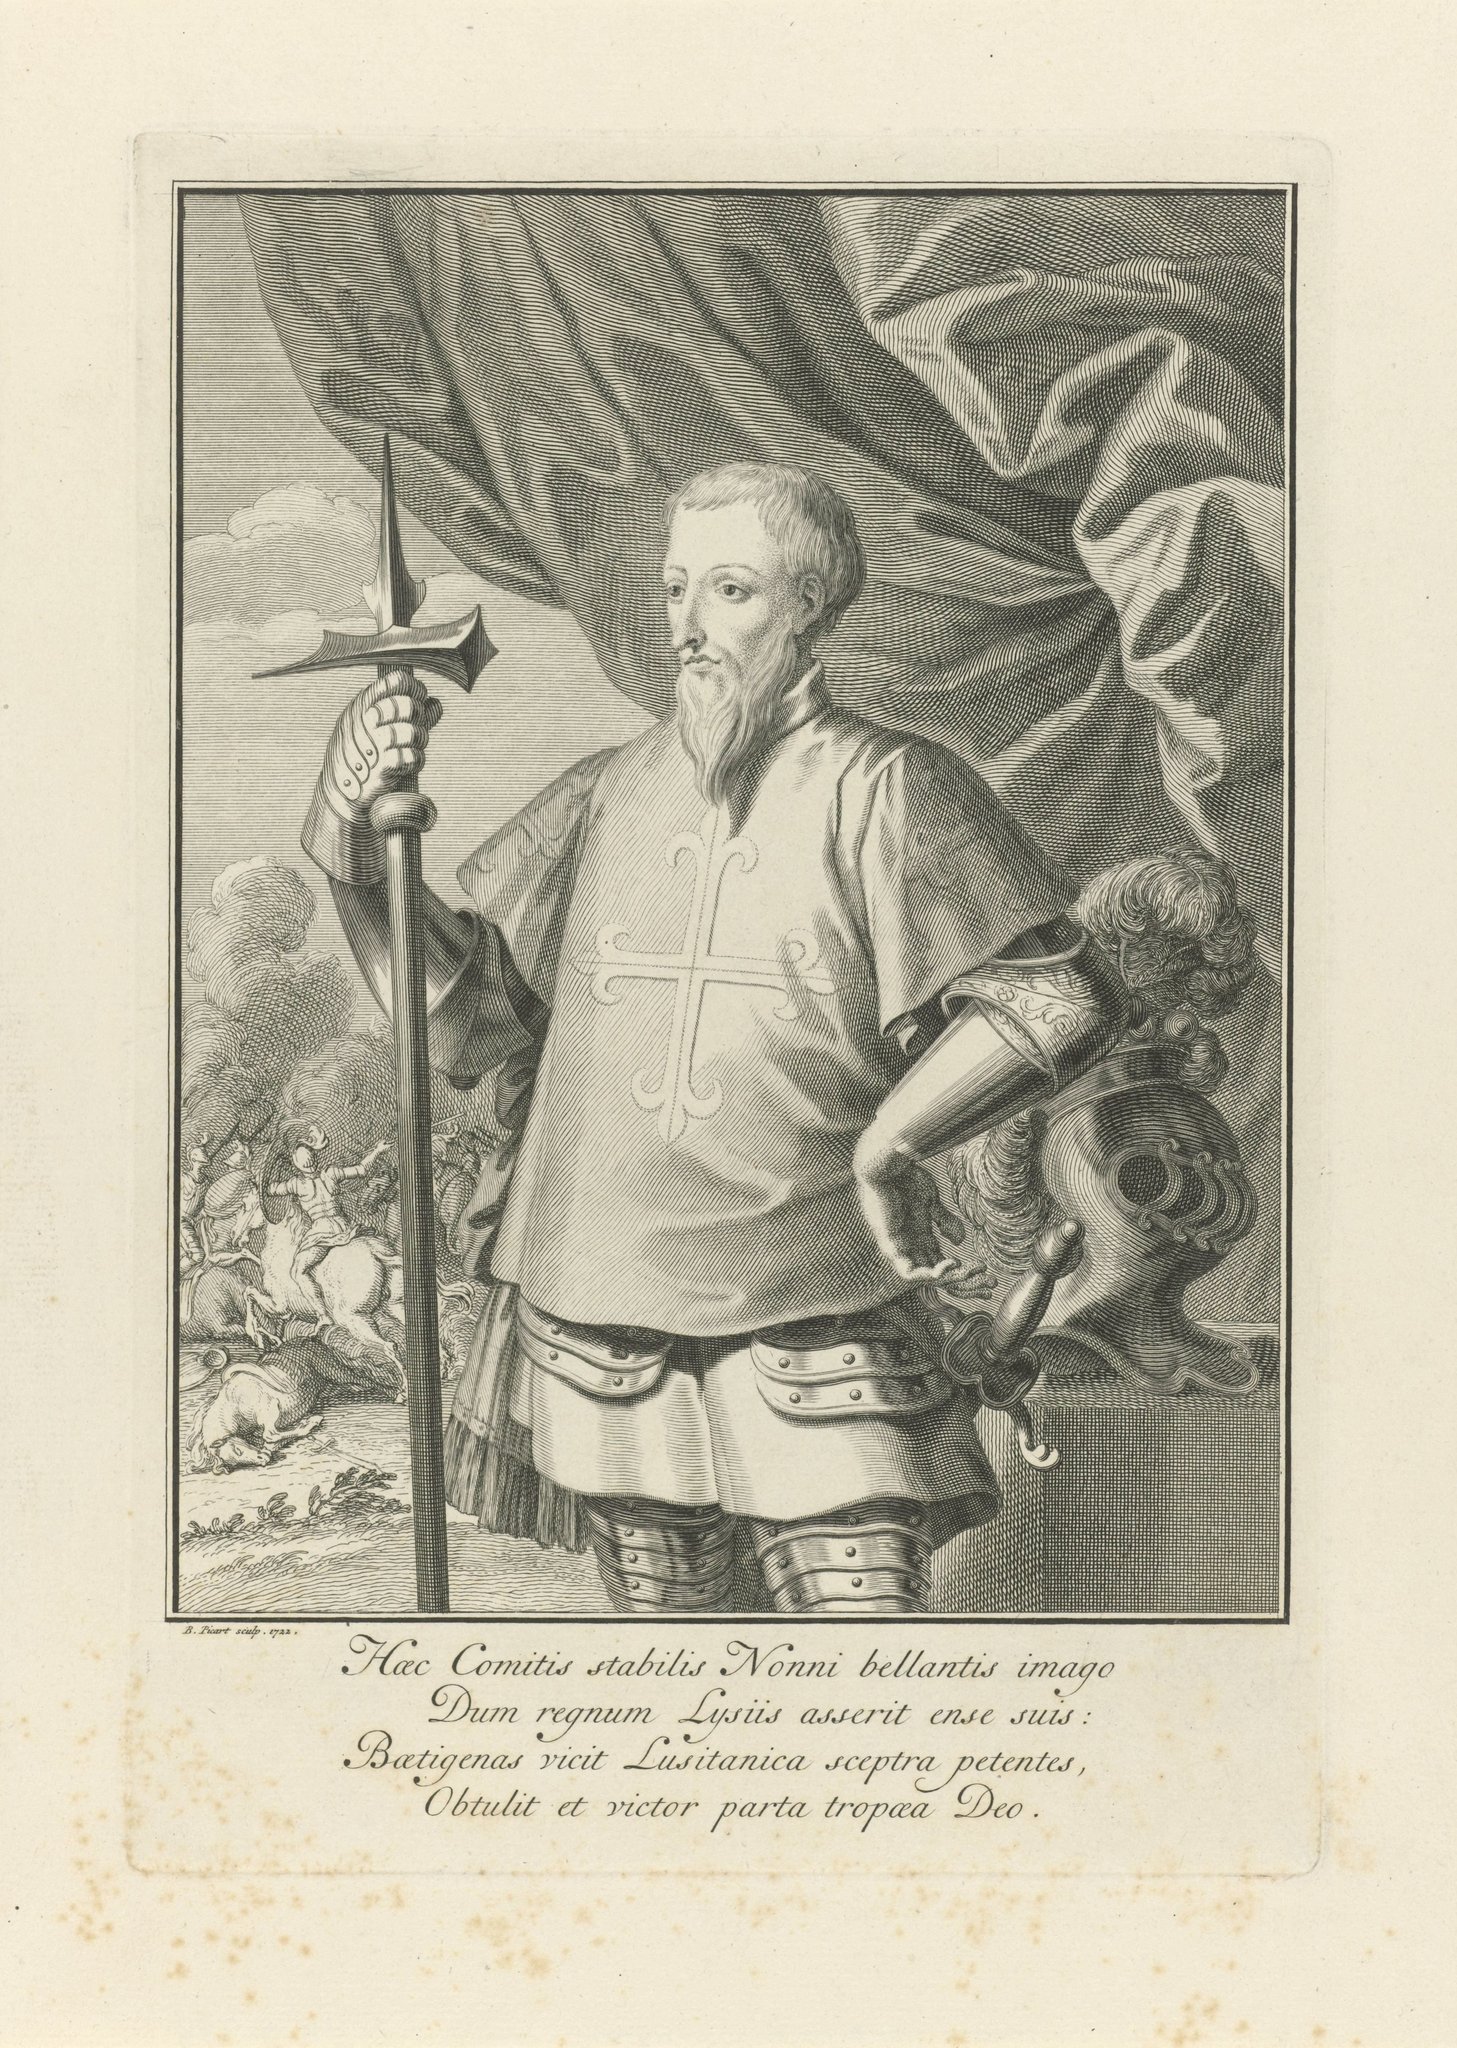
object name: print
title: Portret van Nuno Álvares Pereira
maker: bernard picart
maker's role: draughtsman, print maker, publisher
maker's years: 1673-1733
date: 1722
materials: paper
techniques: engraving, etching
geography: amsterdam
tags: commander-in-chief, general, marshal, battle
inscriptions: collector's mark: Lugt 240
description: Portret van de Portugese generaal Nuno Álvares Pereira. Op de achtergrond een veldslag. In de marge een vierregelig onderschrift in het Latijn.